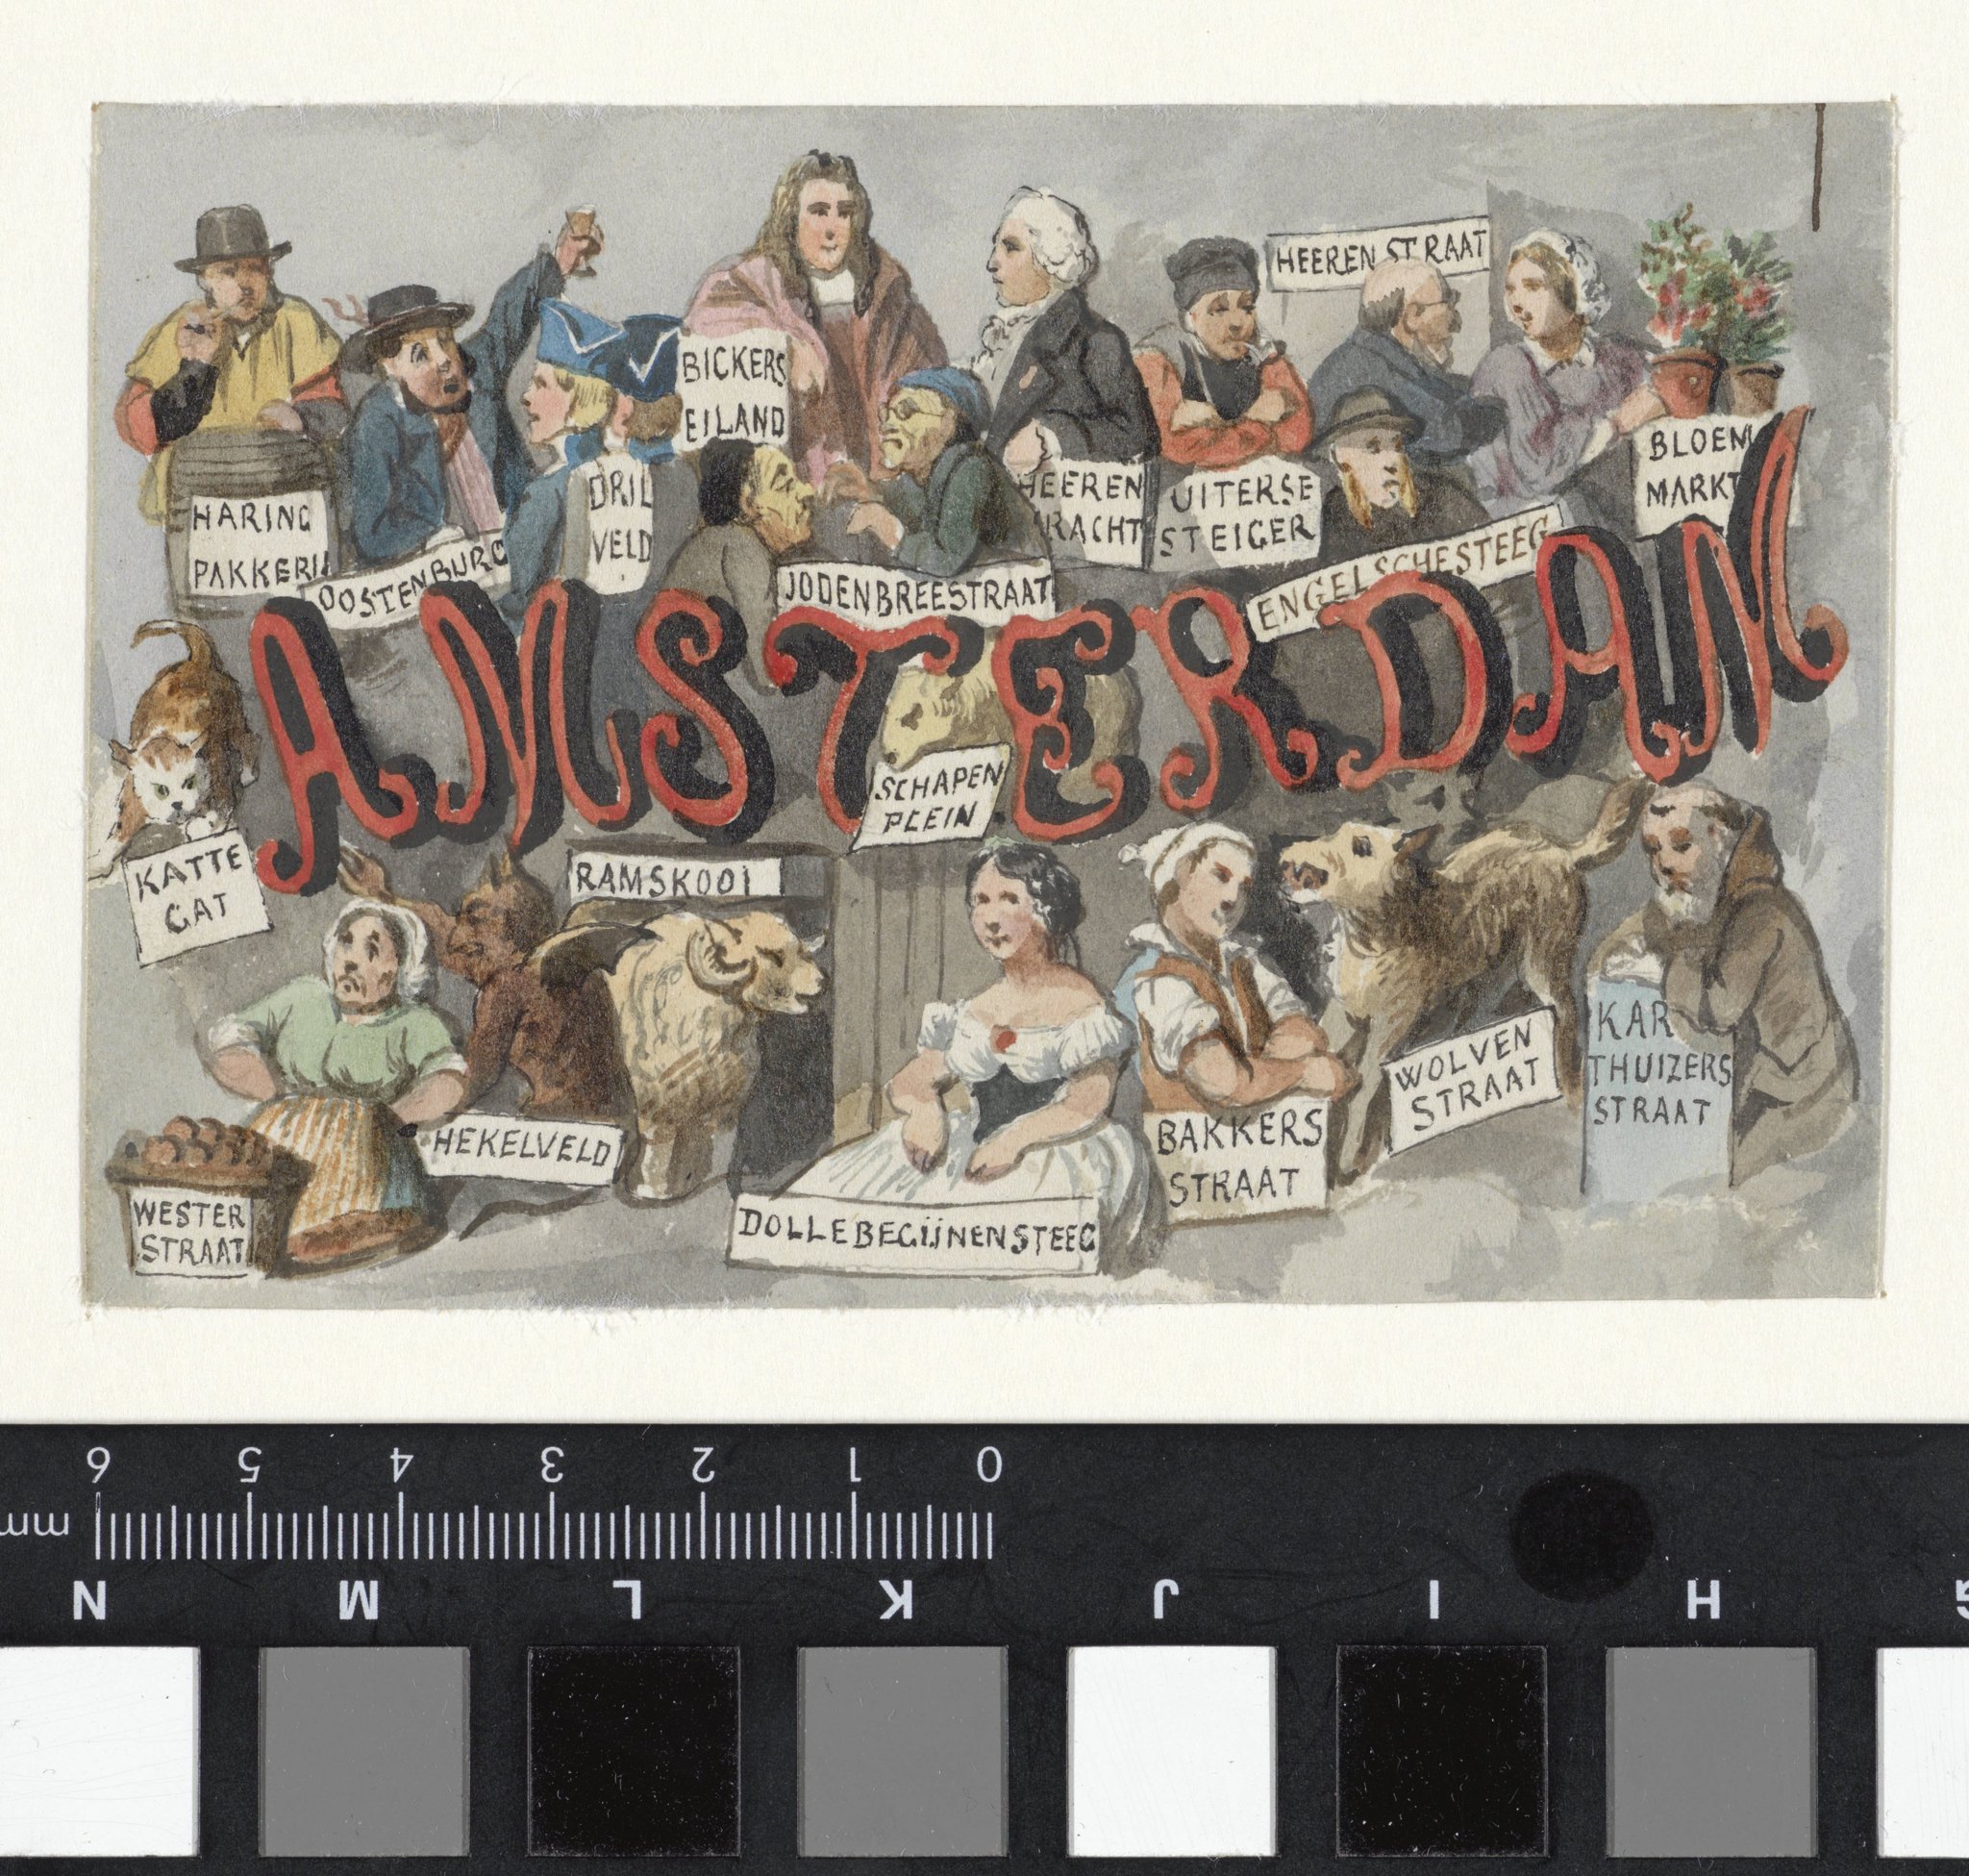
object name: drawing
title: Tweede ontwerp voor de omslag van Amsterdam, van Johannes ter Gouw, 1865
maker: johan coenraad leich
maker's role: draughtsman, print maker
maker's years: 1823-1890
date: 1860-1865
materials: ink, paper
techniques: brush, pen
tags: (ter gouw, amsterdam) specific works of literature (with author, title), street, amsterdam